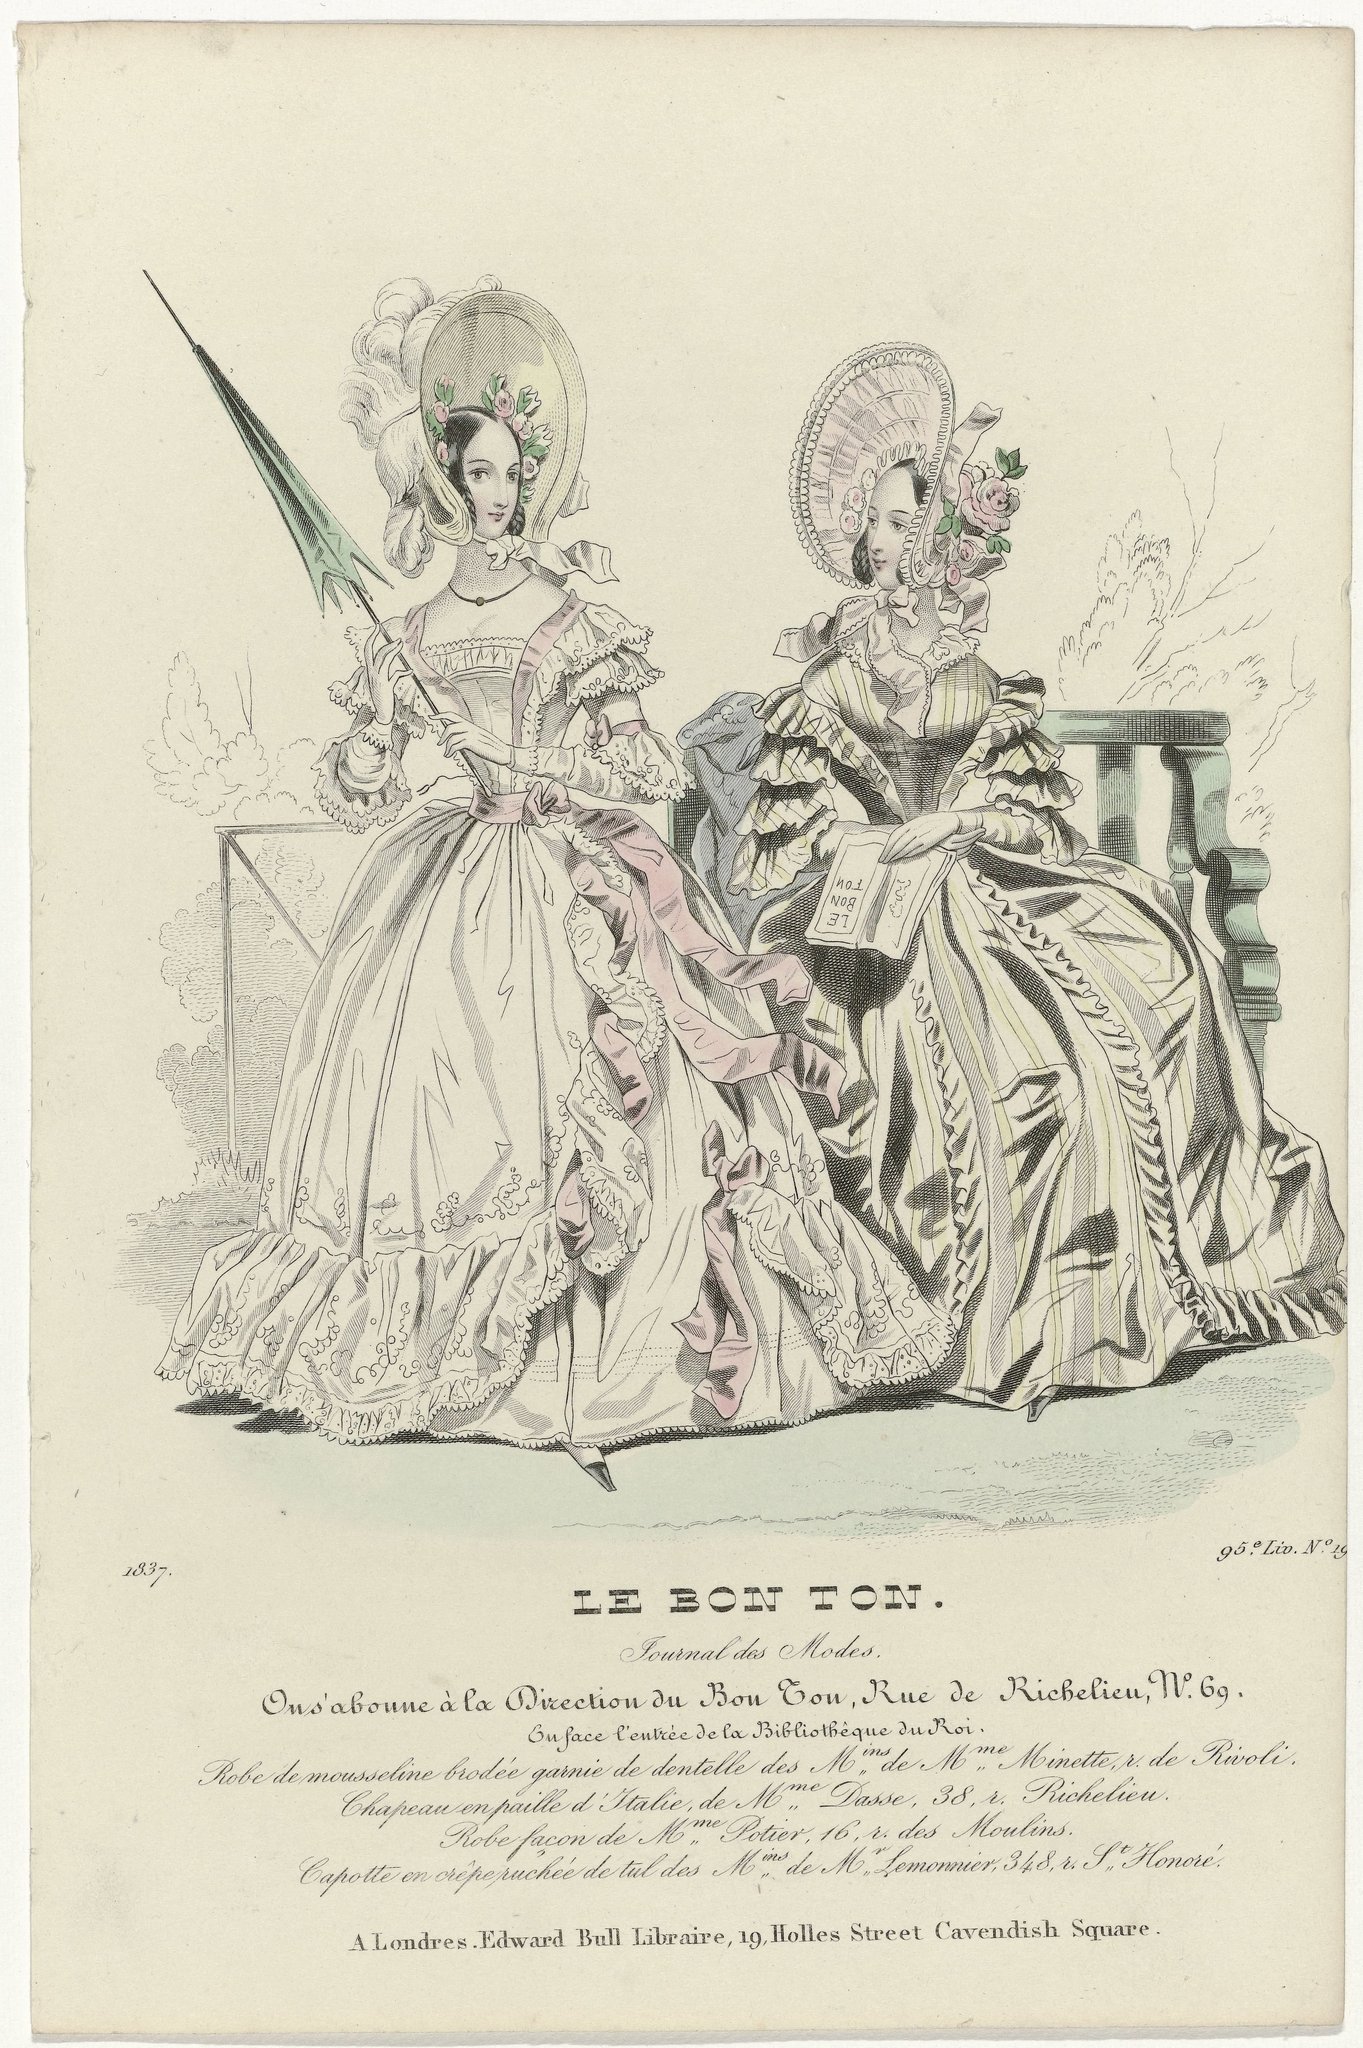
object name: fashion print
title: Le Bon Ton, Journal des Modes, 1837, 95e Liv. No. 190: Robe de mousseline brodé (...)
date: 1837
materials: paper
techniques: engraving, hand coloring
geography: london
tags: head-gear (capote) (+ women's clothes), embroidery (ornamentation) (+ women's clothes), lace (+ women's clothes), fashion plates, head-gear: hat (+ women's clothes), shoes, sandals (+ women's clothes), gloves, mittens, etc. (+ women's clothes), dress, gown (+ women's clothes), book - mm - book open, necklace (+ women's clothes), parasol, sunshade (+ women's clothes)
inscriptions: address: ‘On s'abonne à la Direction du Bon Ton, Rue de Richelieu, No. 69. / En face l'entrée de la Bibliothêque du Roi. / A Londres. Edward Bull Libraire, 19, Holles Street Cavendish Square.’, caption: ‘Robe de mousseline brodée garnie de dentelle des M"ins de M"me Minette, r. de Rivoli. Chapeau en paille d'Italie, de M"me Dasse, 38, r. Richelieu. Robe façon de M"me Potier, 16, r. des Moulins. Capotte en crêpe ruchée de tul des M"ins de M"r Lemonnier, 348, r. S"t Honoré.’, title: ‘Le Bon Ton. / Journal des Modes.’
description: Twee vrouwen in een tuin. De zittende vrouw heeft het modetijdschrift 'Le Bon Ton' in de hand. Volgens het onderschrift: japon van geborduurde mousseline versierd met kant uit de winkels van Minette. Luifelhoed van 'paille d'Italie' van Dasse. Japon, uitgevoerd op de manier van Potier. 'Capote' van crêpe afgezet met ruches van tule uit de winkels van Lemonnier. Prent uit het modetijdschrift Le Bon Ton (1834-1884).